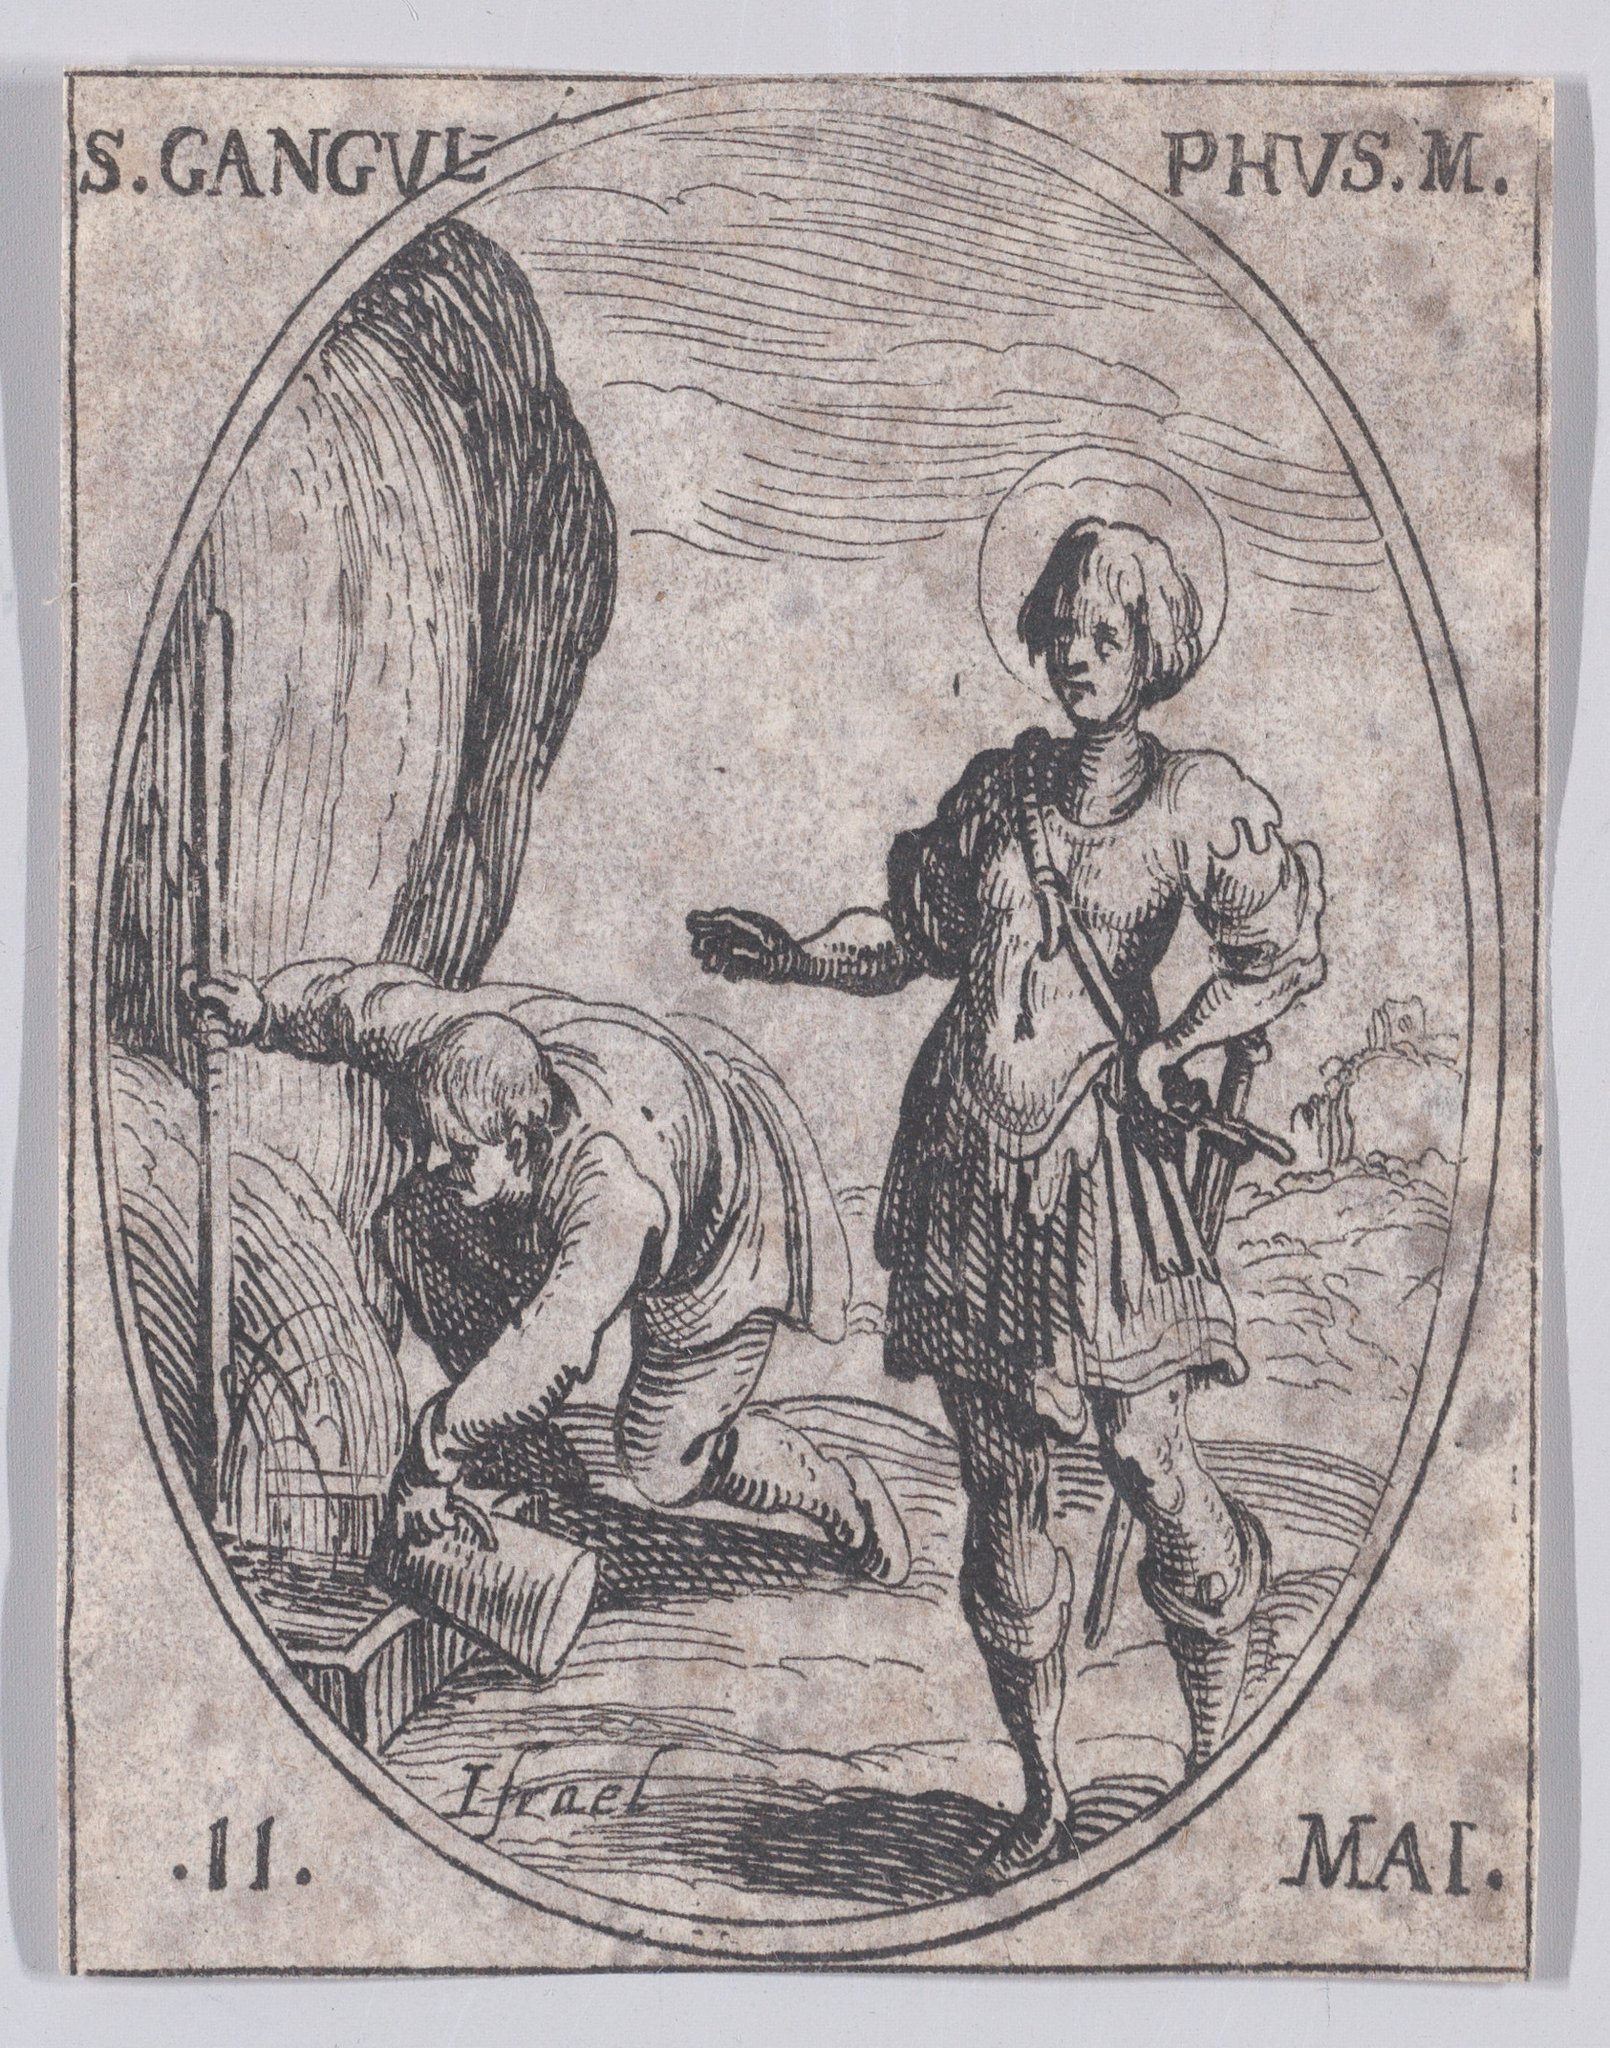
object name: print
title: S. Gangulphe, martyr (St. Gangulphus, Martyr), May 11th, from "Les Images De Tous Les Saincts et Saintes de L'Année" (Images of All of the Saints and Religious Events of the Year)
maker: jacques callot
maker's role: artist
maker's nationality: french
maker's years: 1592-1635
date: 1636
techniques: etching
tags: men,saints